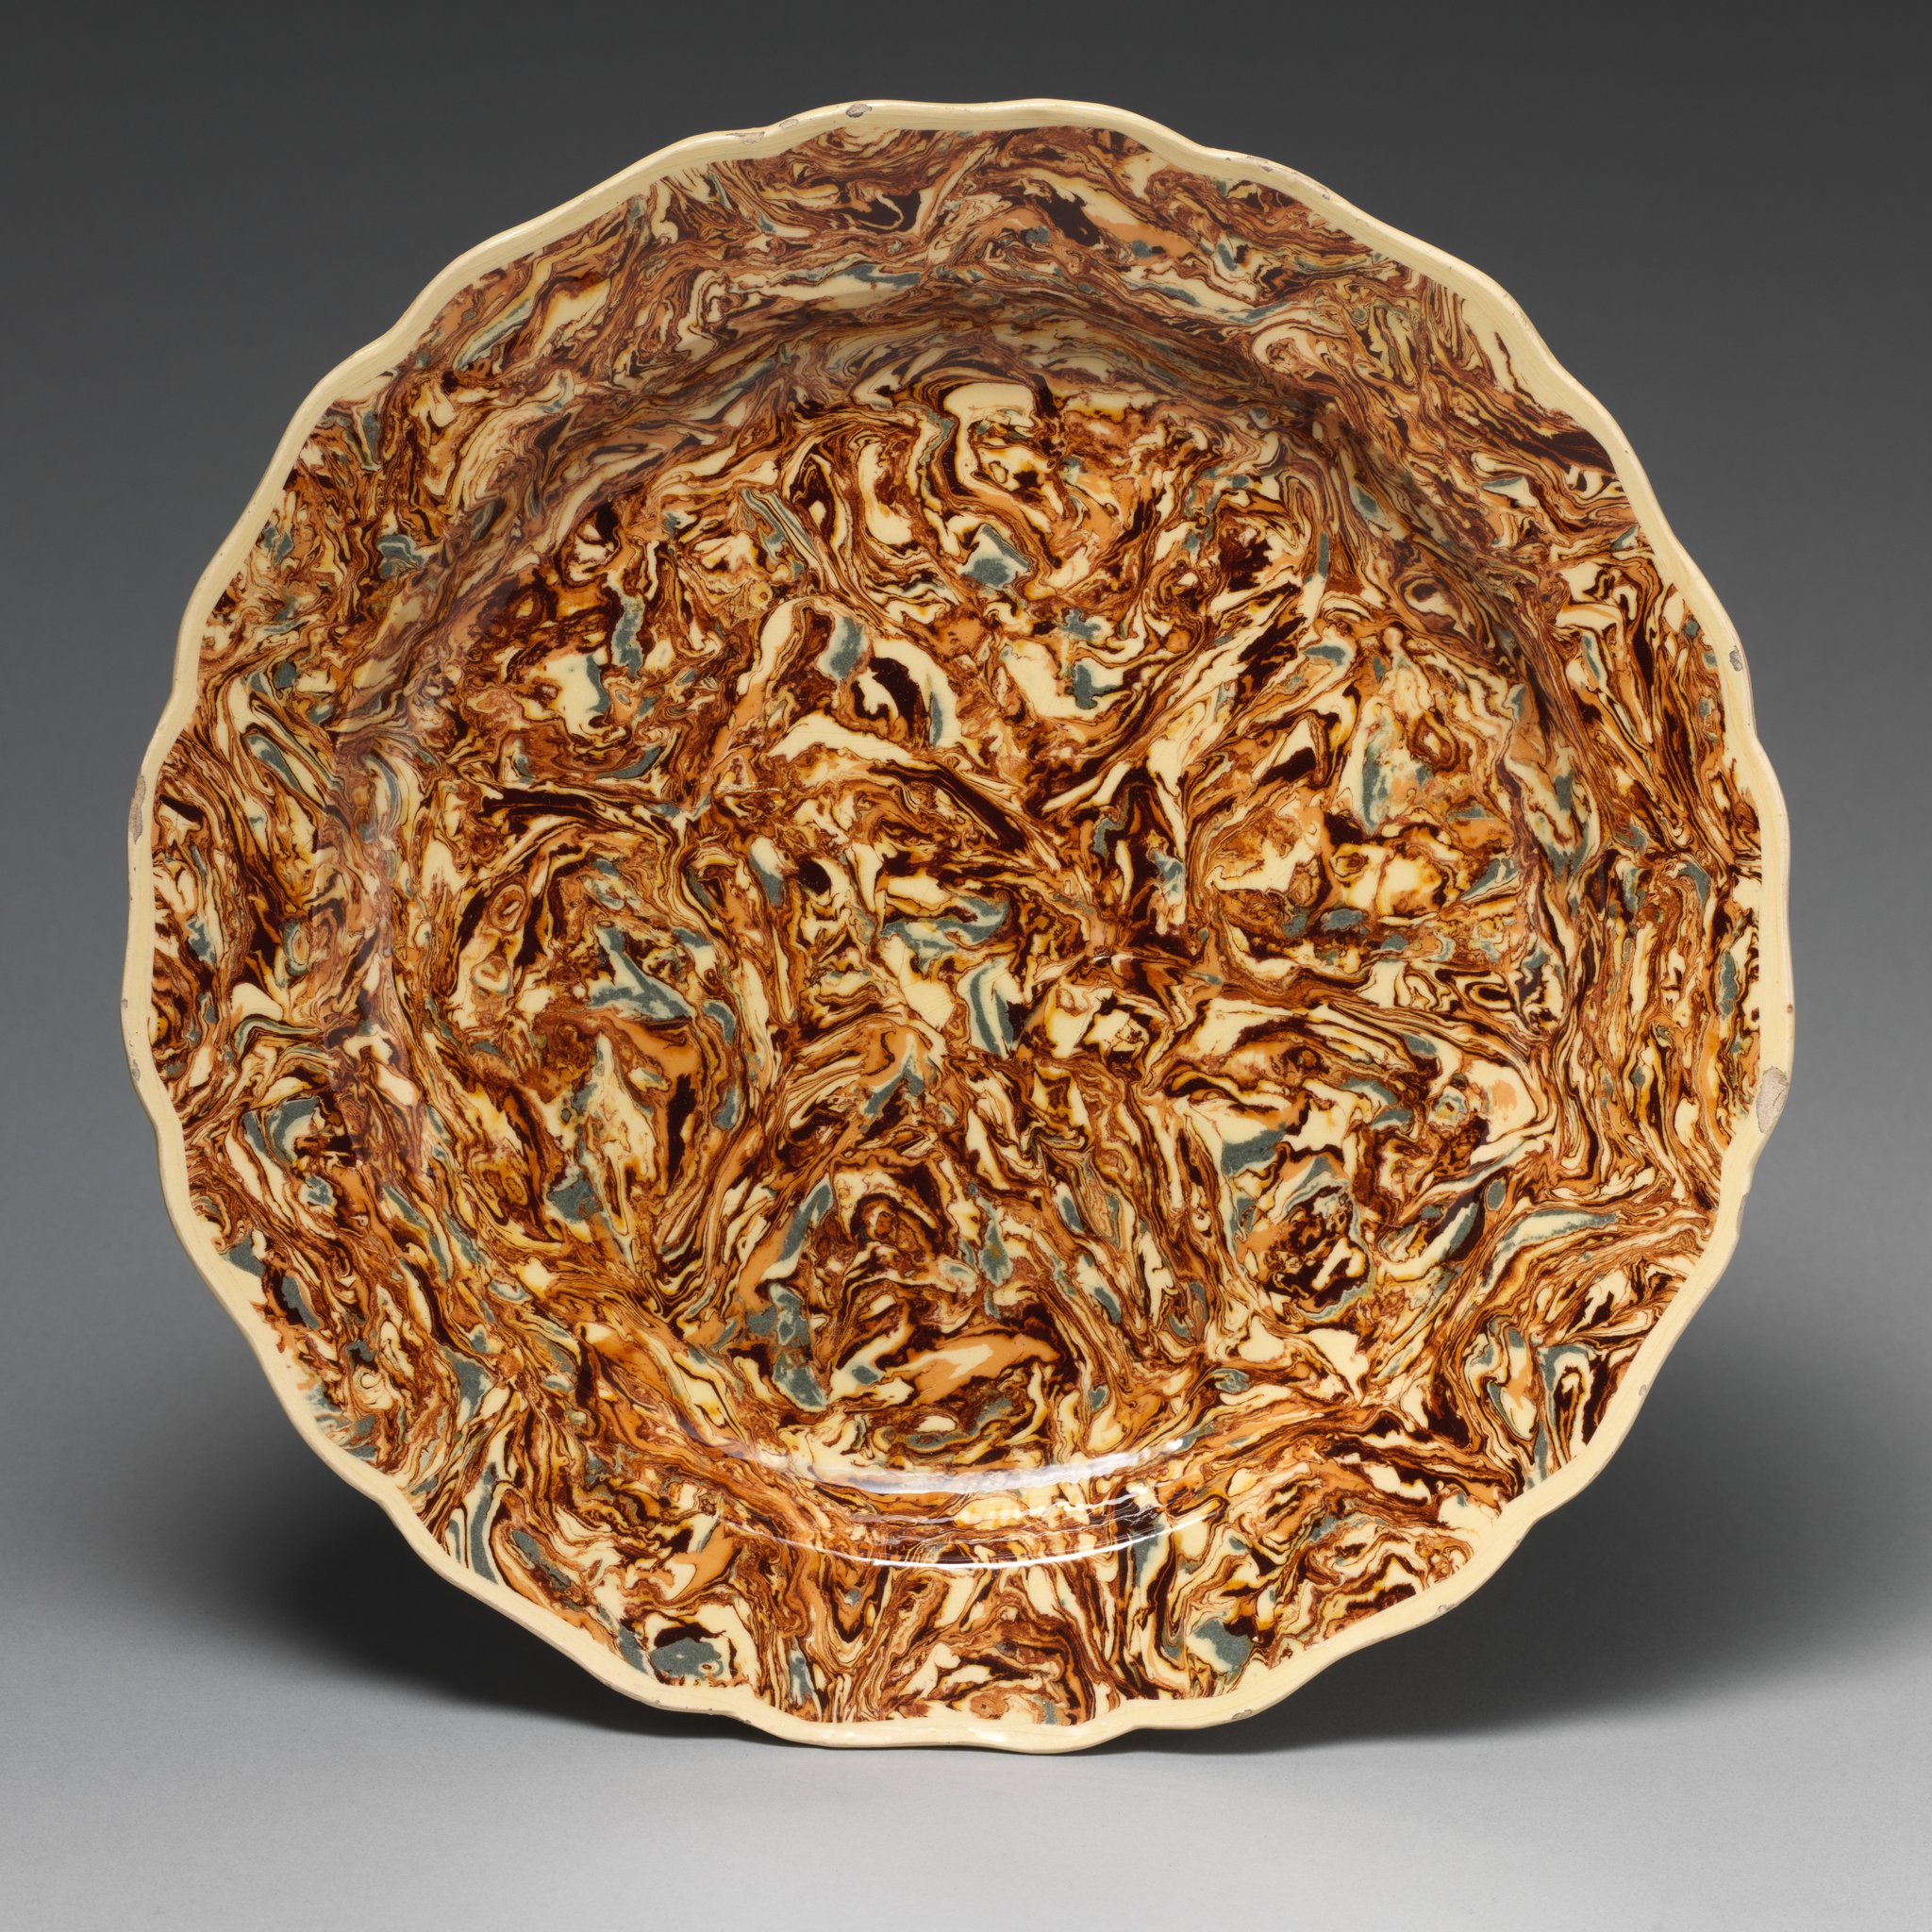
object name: écuelle stand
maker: moulin manufactory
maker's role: maker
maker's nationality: french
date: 1793-1830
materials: faience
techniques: glazing